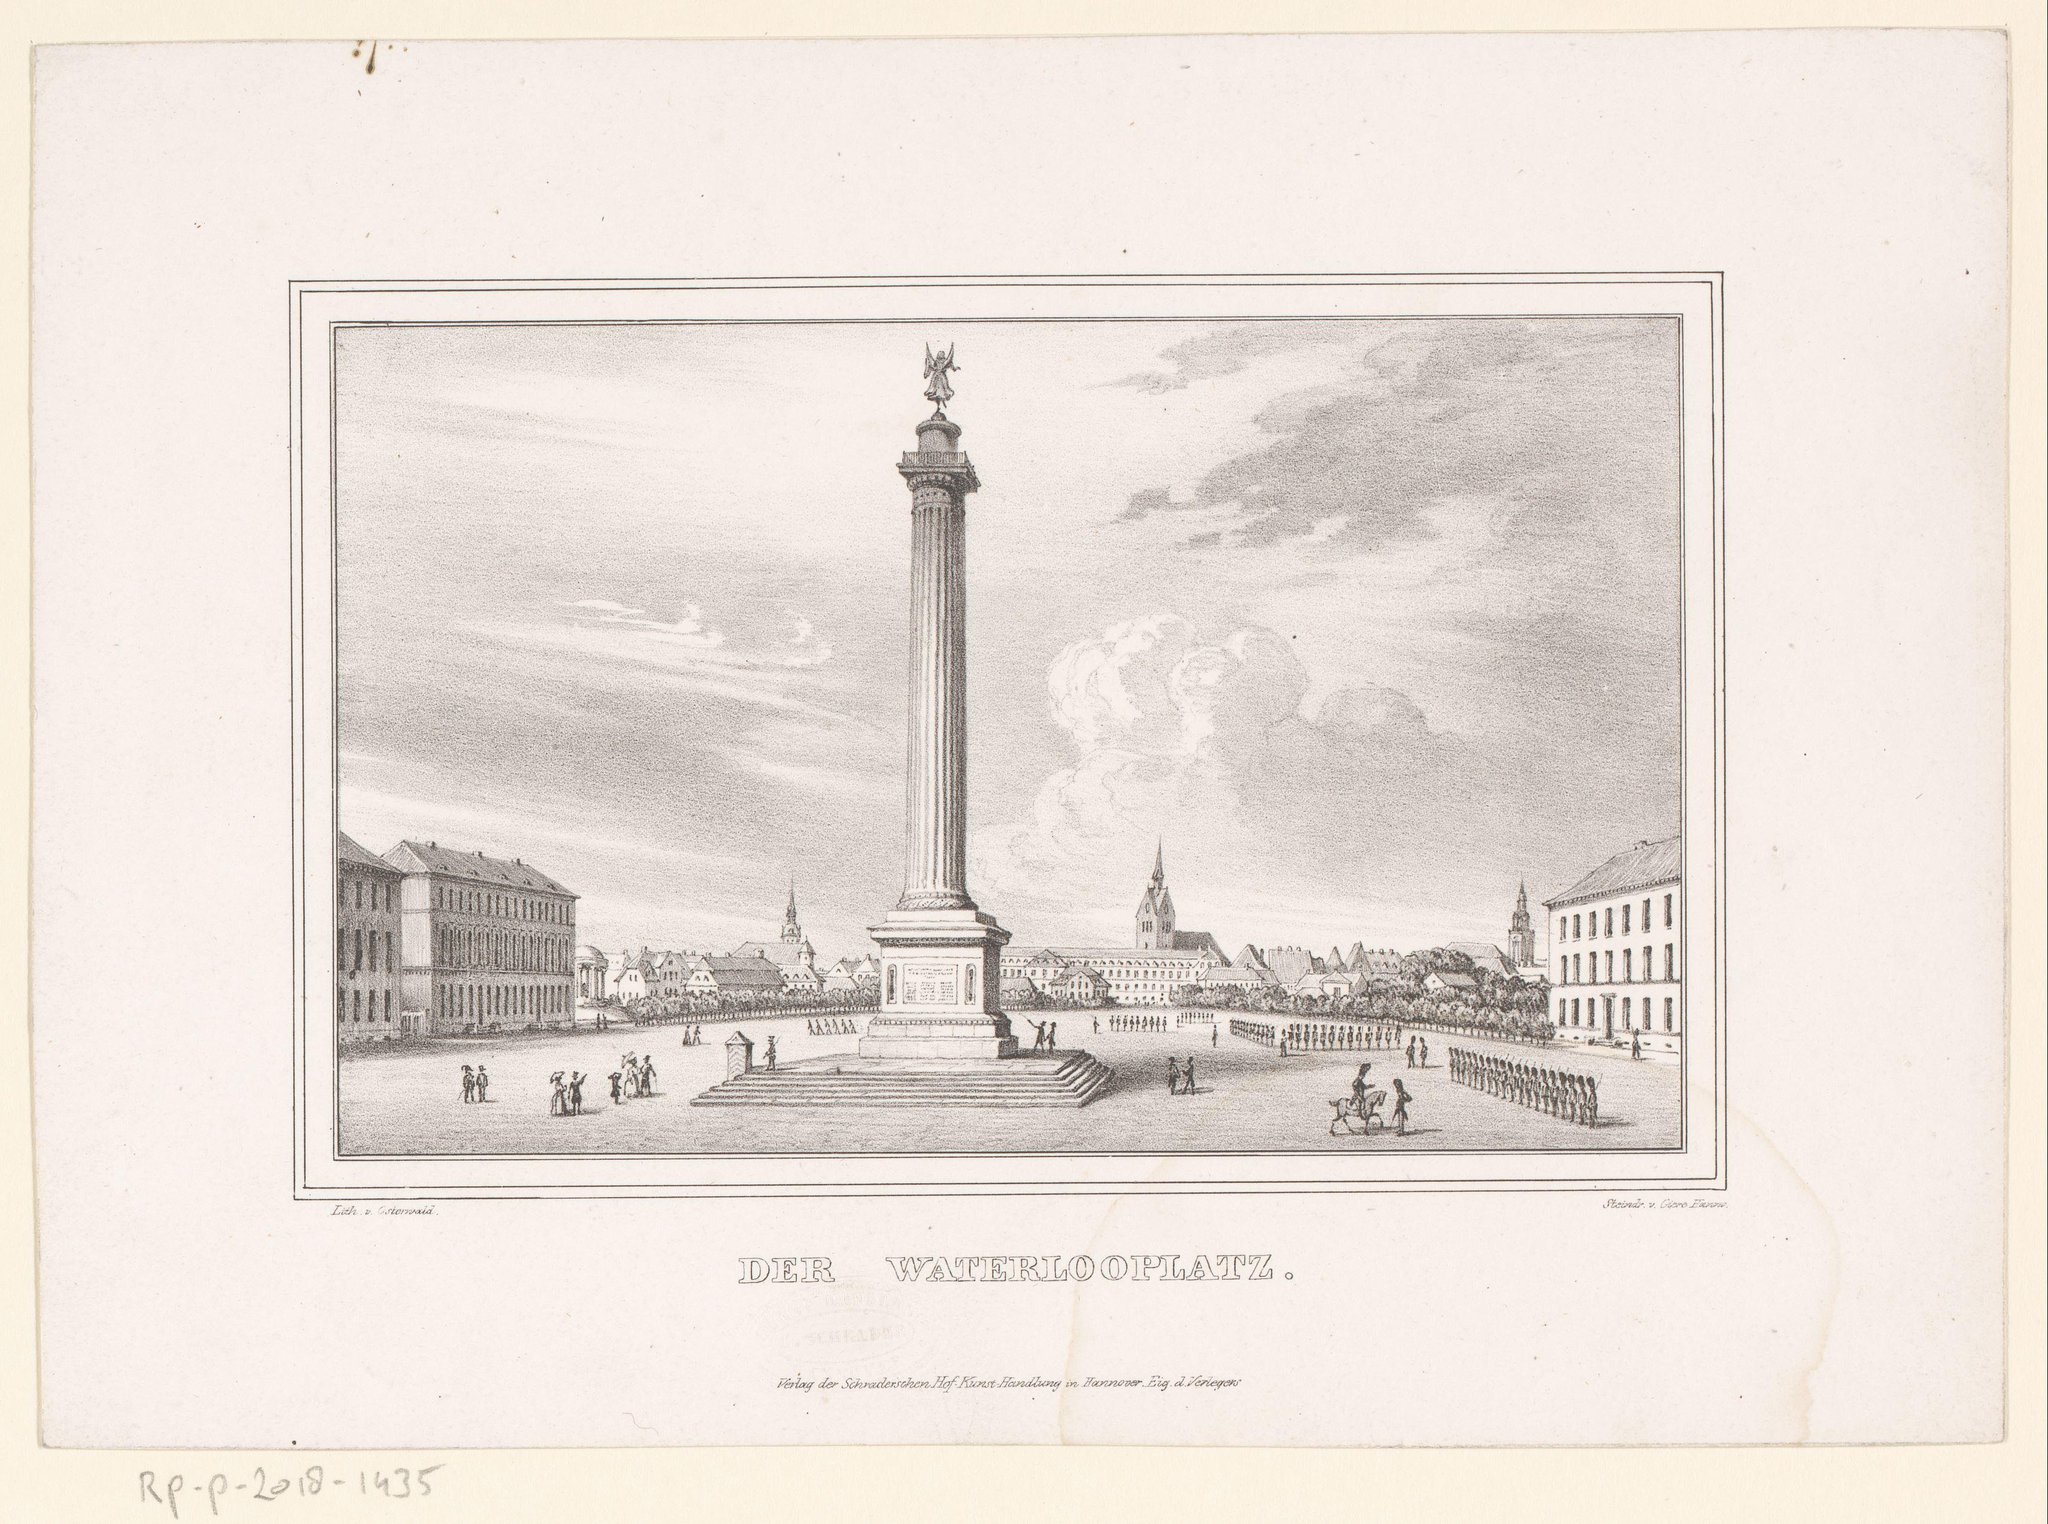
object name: print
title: Gezicht op het Waterlooplatz, te Hannover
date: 1832-1845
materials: paper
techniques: lithograph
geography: hannover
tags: monument, statue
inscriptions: check stamp: ‘C. Schrader. Kunst Handlung Hannover’